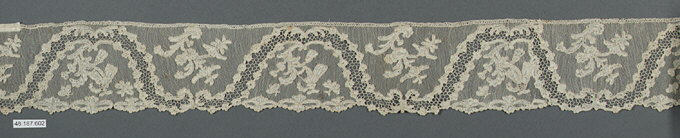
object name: border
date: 1751-1800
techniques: lace